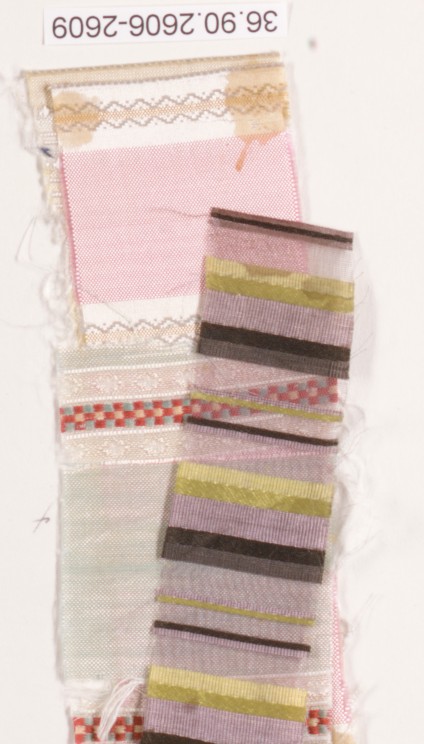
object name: ribbon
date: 1801-1900